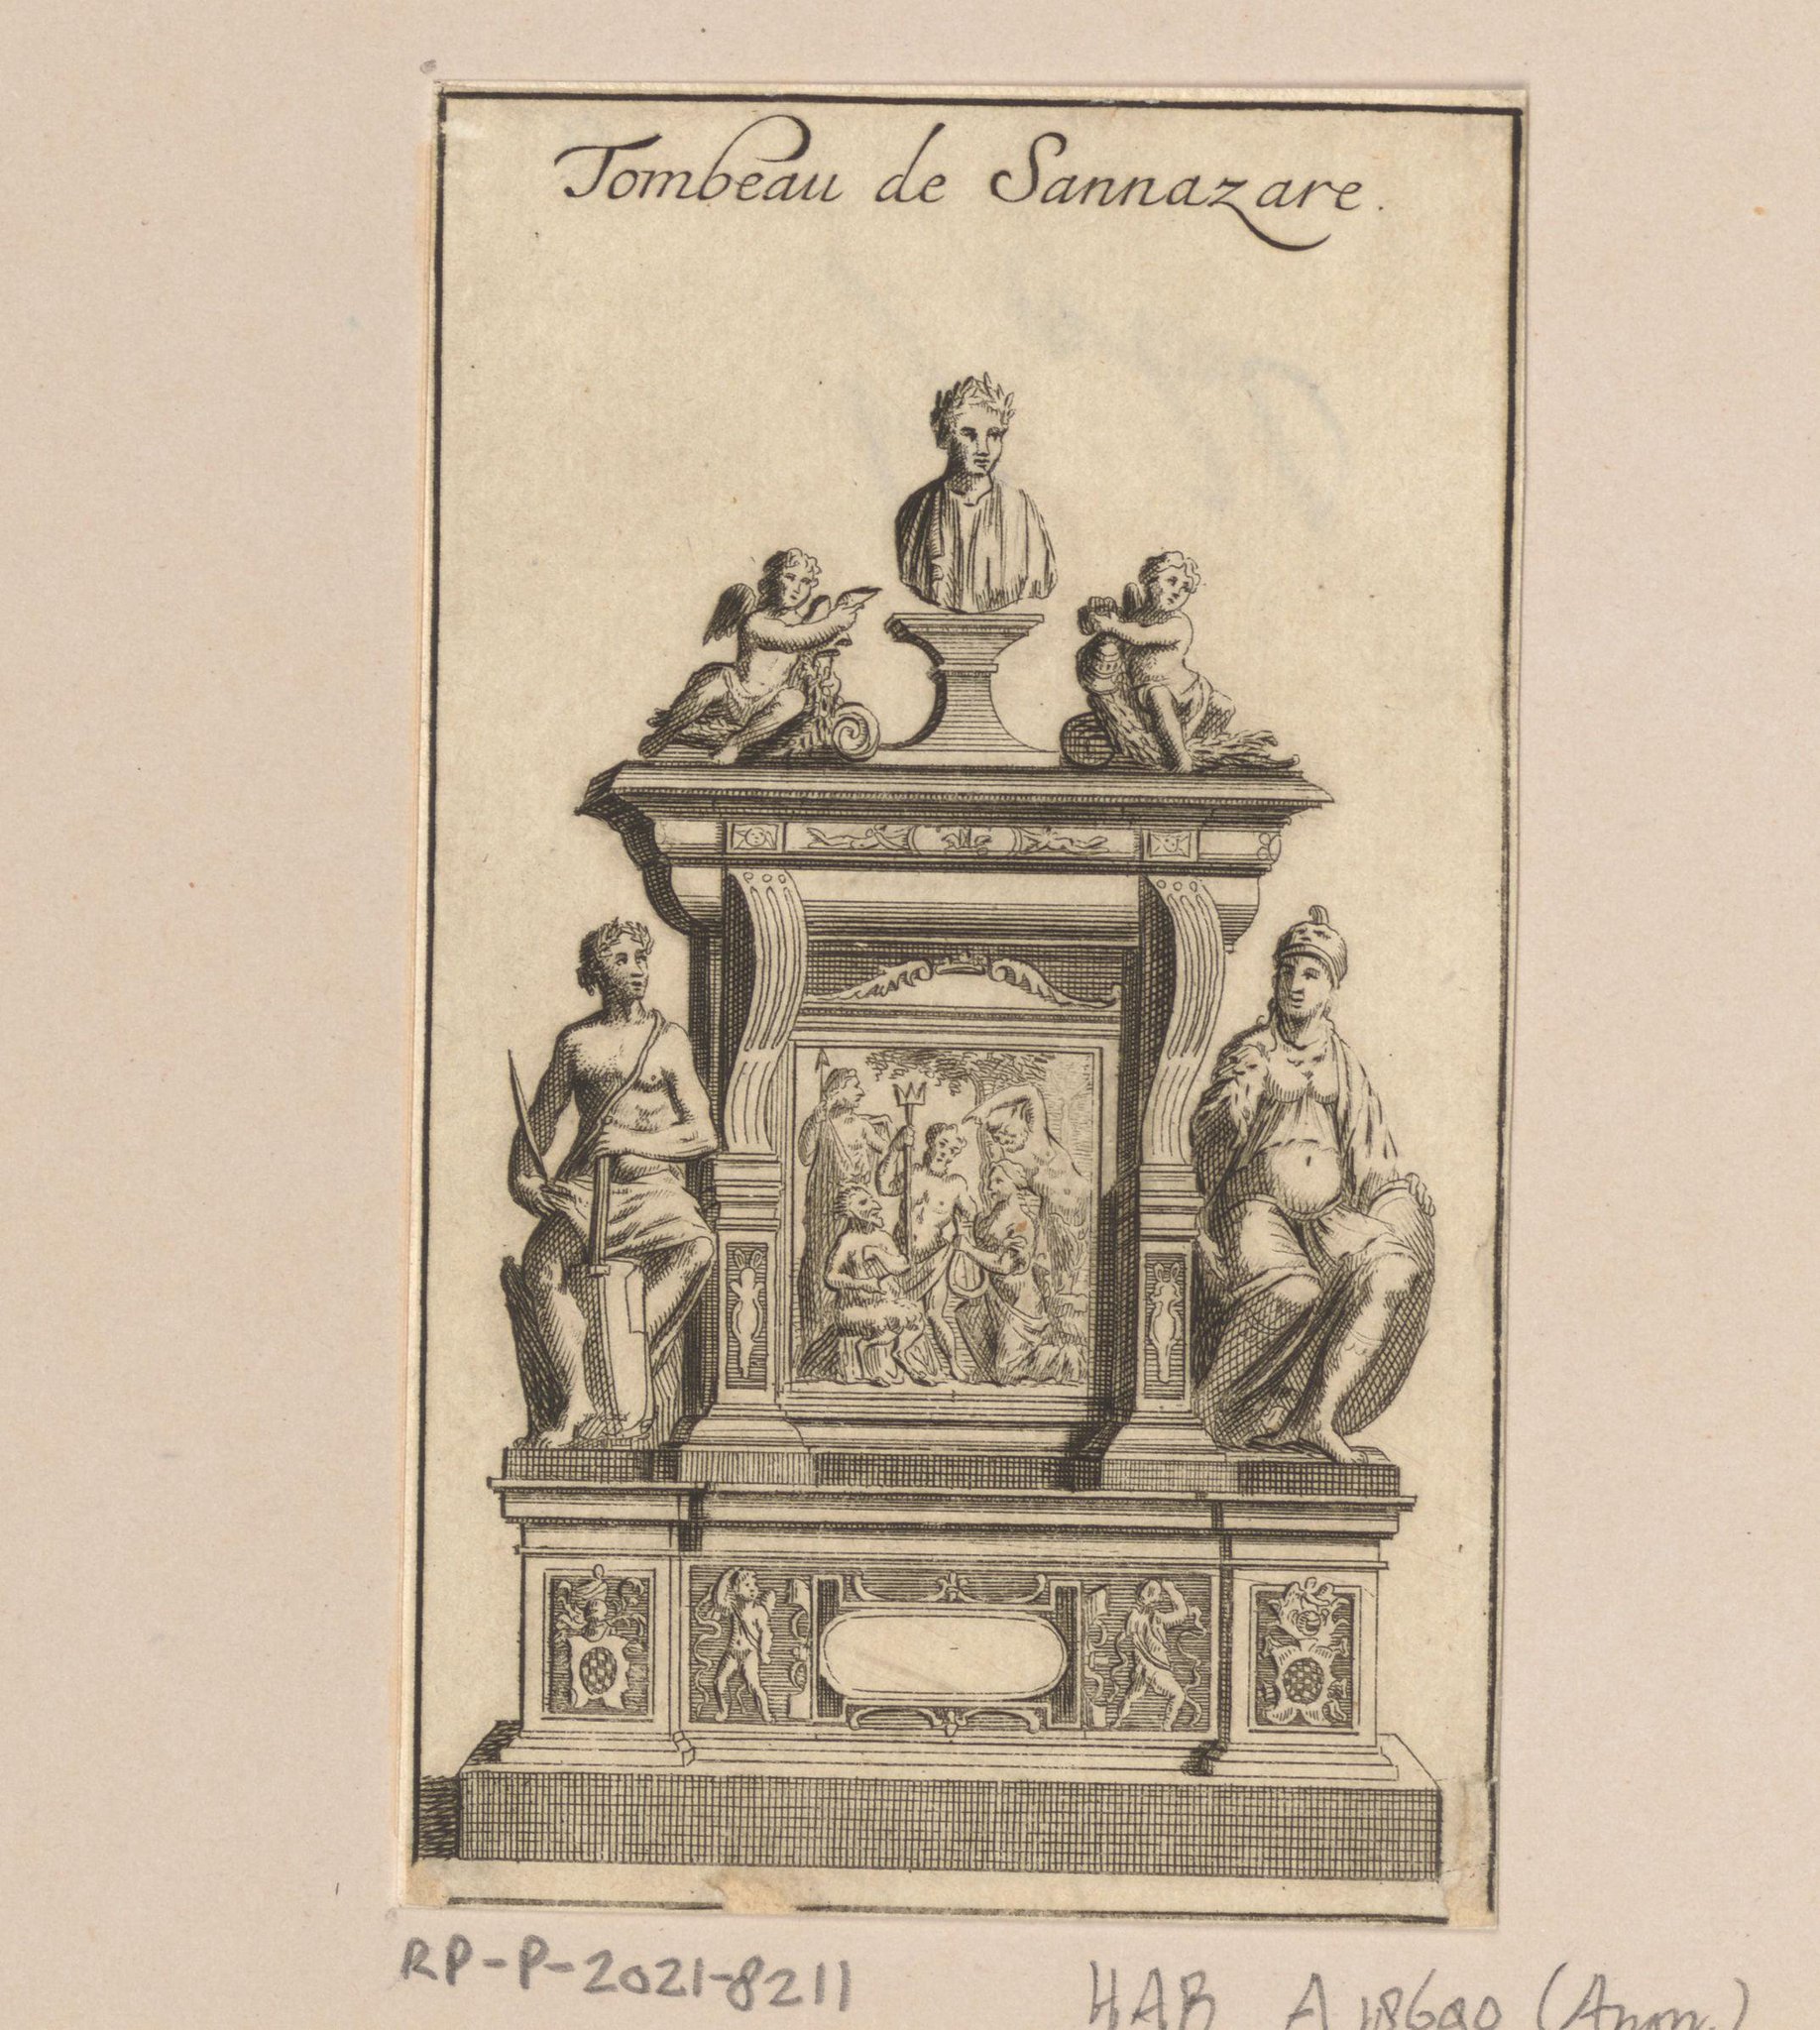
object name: print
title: Grafmonument met het portret van Jacopo Sannazaro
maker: Anonymous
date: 1698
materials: paper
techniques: etching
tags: naples, rome, jacopo sannazaro, historical persons, grave-building, monumental tomb, cupids: 'amores', 'amoretti', 'putti'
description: Prent waarschijnlijk uit: Misson, Maximilien. Nouveau voyage d'Italie, avec un mémoire contenant des avis utiles (...). 3e druk. Den Haag: Henry van Bulderen, 1698, dl. 2, p. 88.